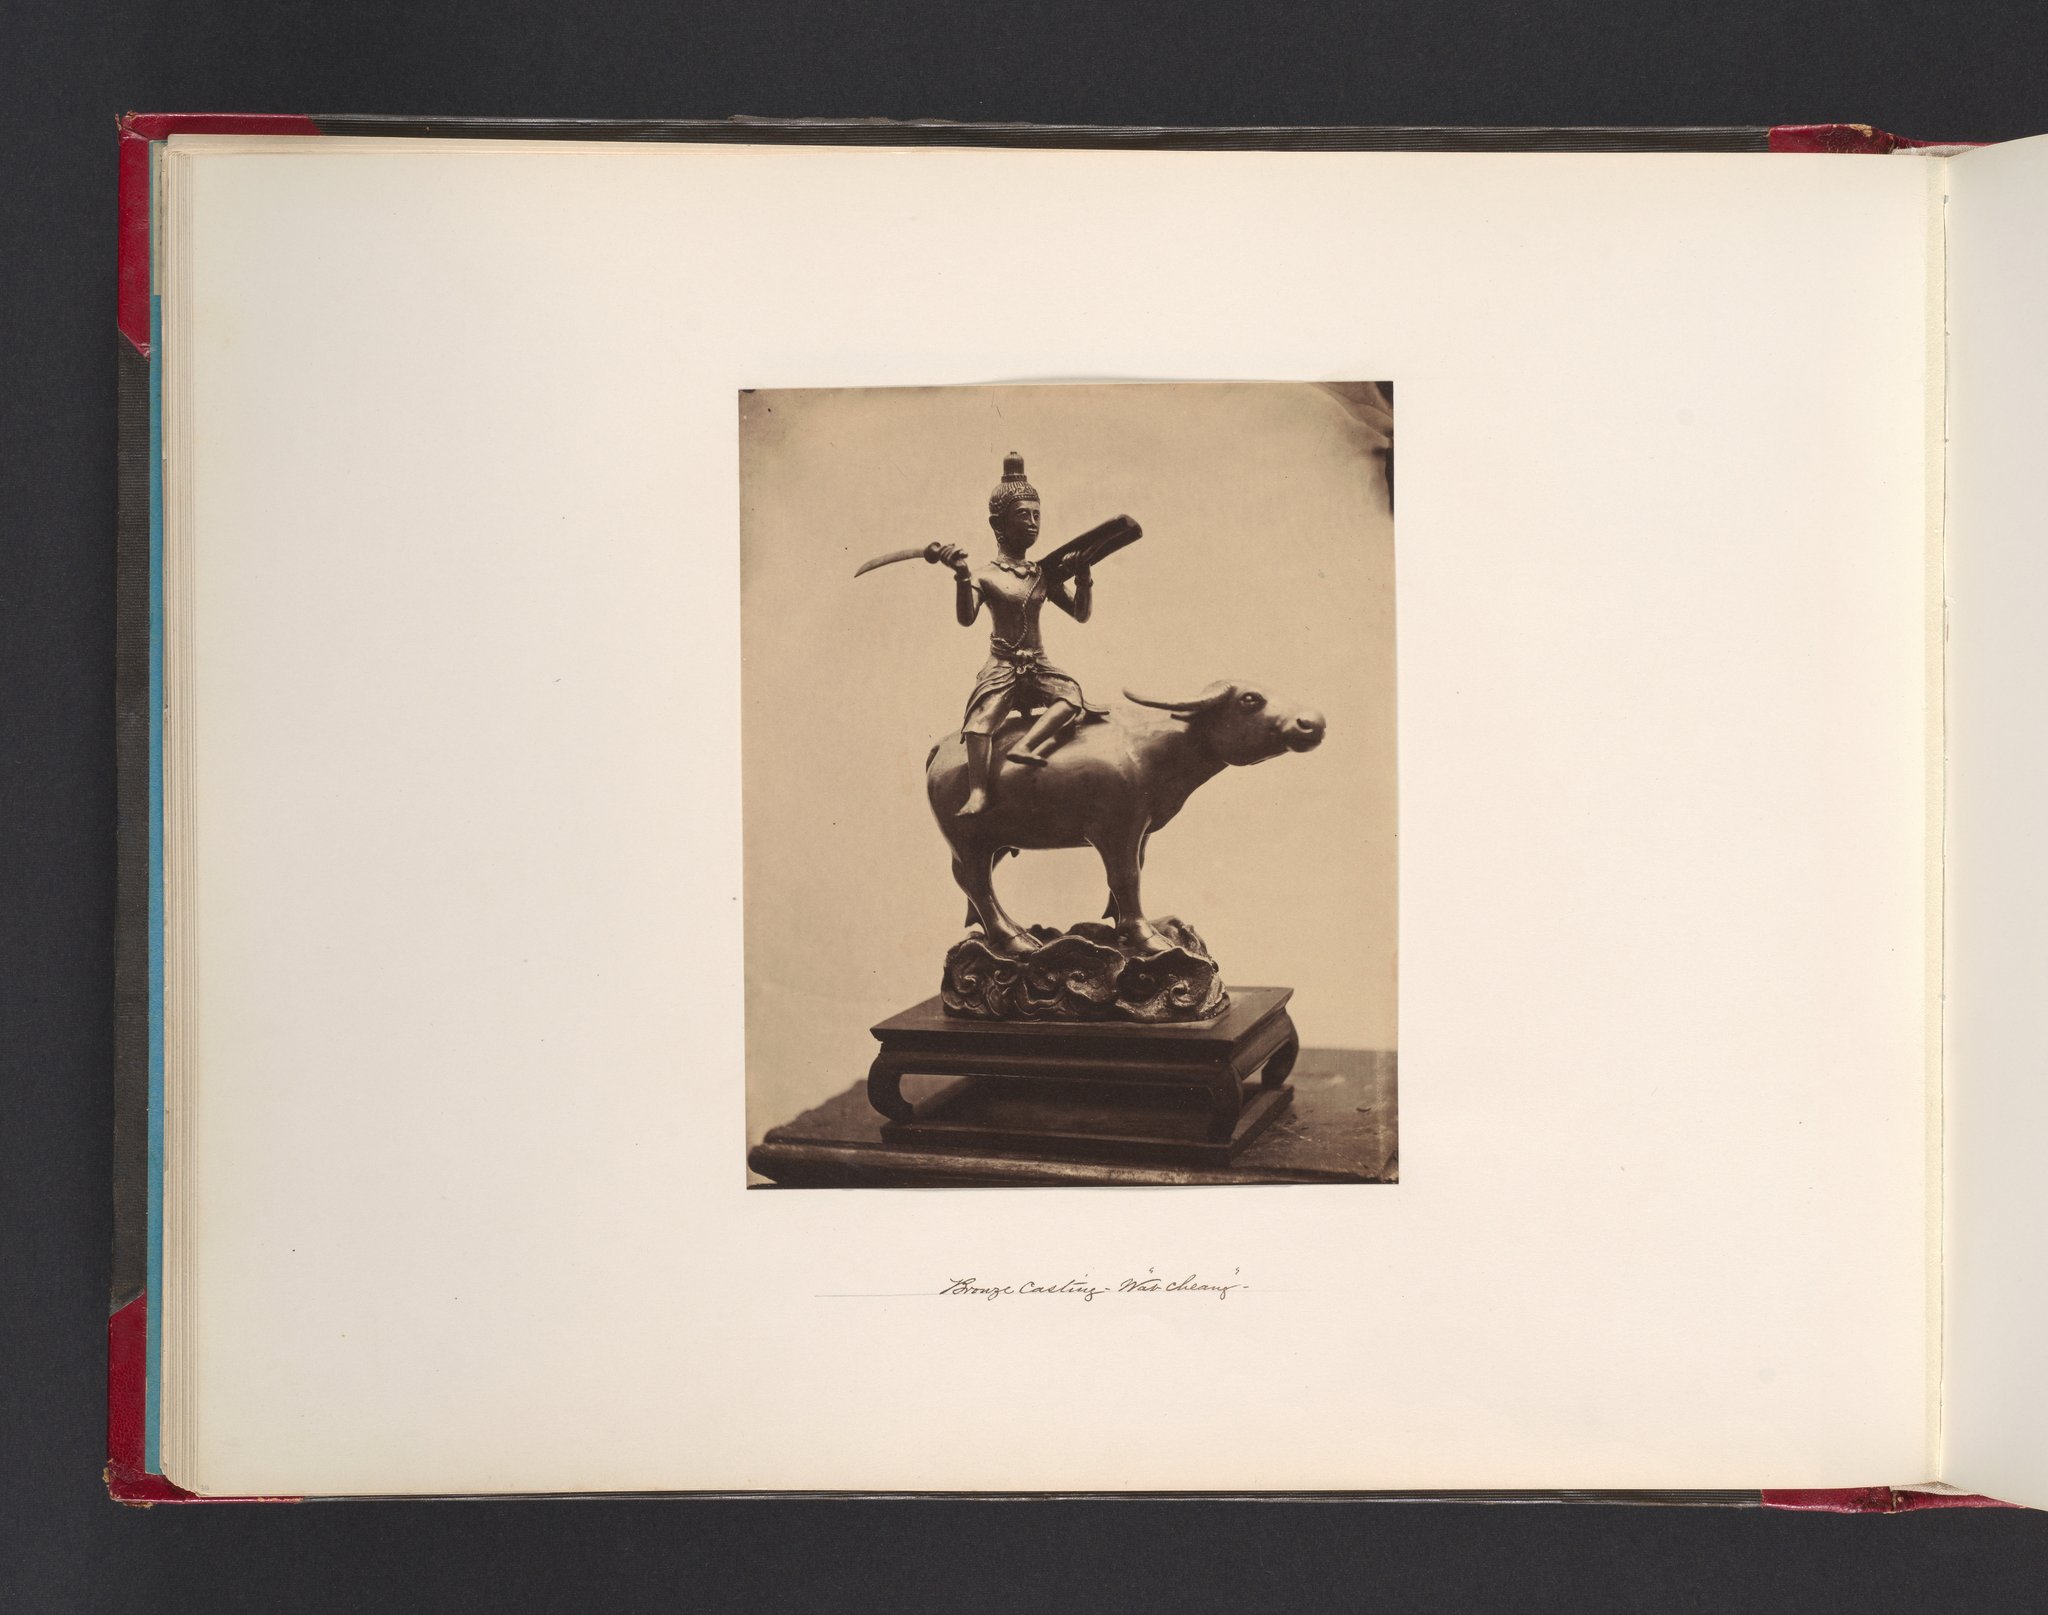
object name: photograph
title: Bronze Casting Wat "Cheang"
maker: john thomson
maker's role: artist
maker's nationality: british, scottish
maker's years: 1837-1921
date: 1865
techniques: albumen silver print, glass negative